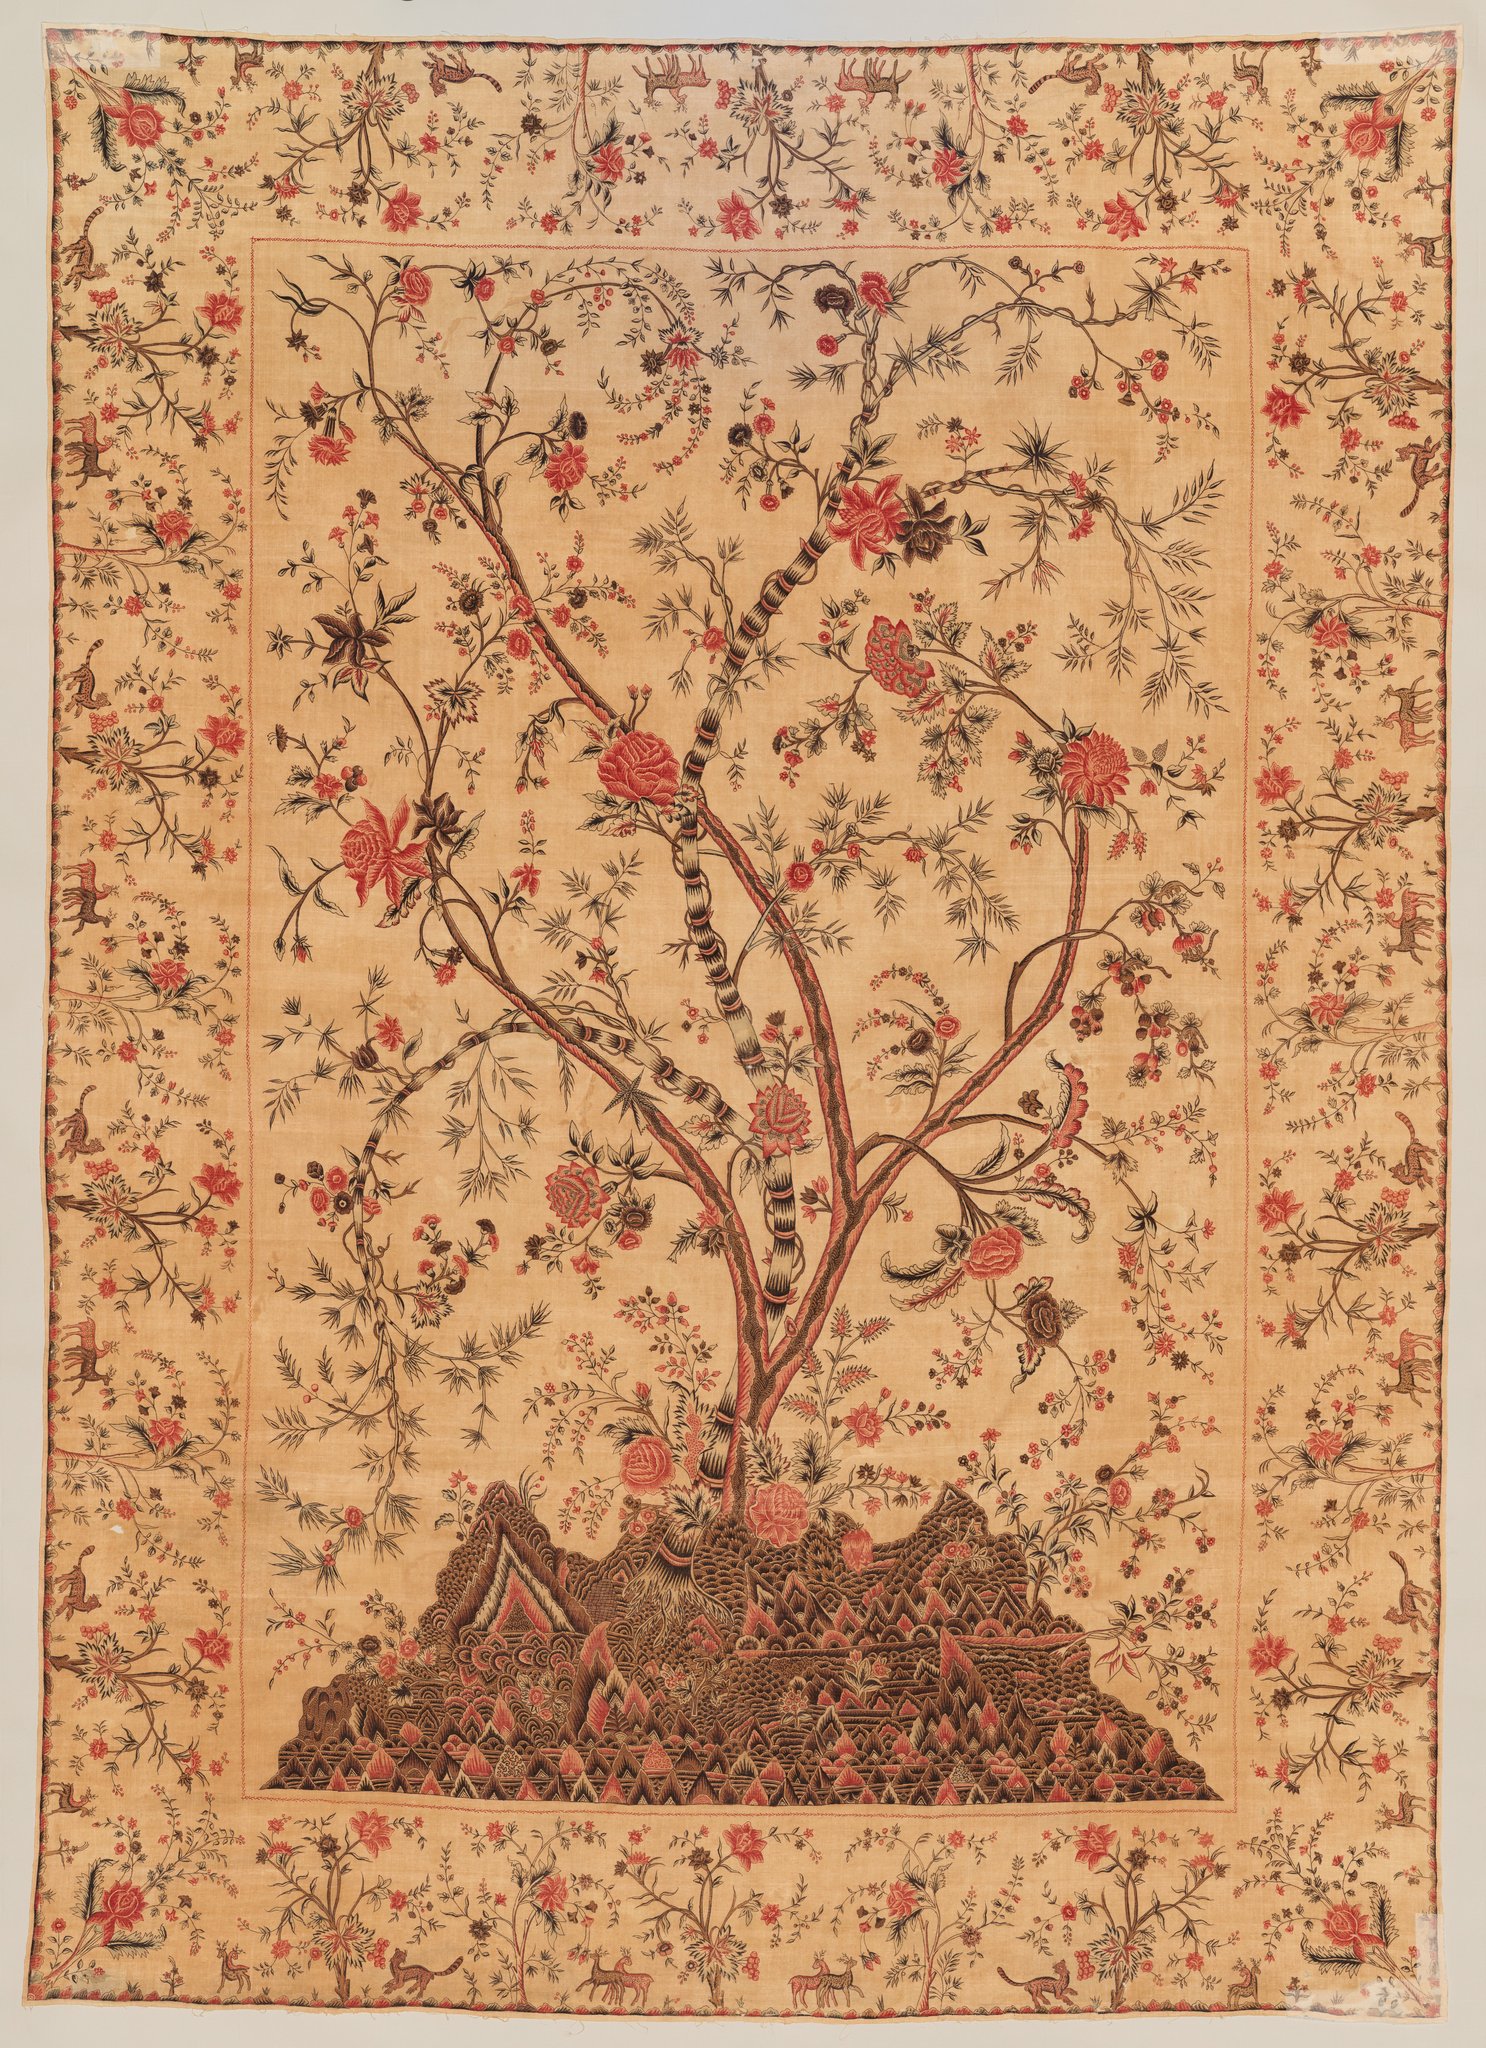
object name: bed cover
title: Bed Cover (Palampore)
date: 1701-1733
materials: cotton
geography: india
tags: deer,tigers,flowers,trees